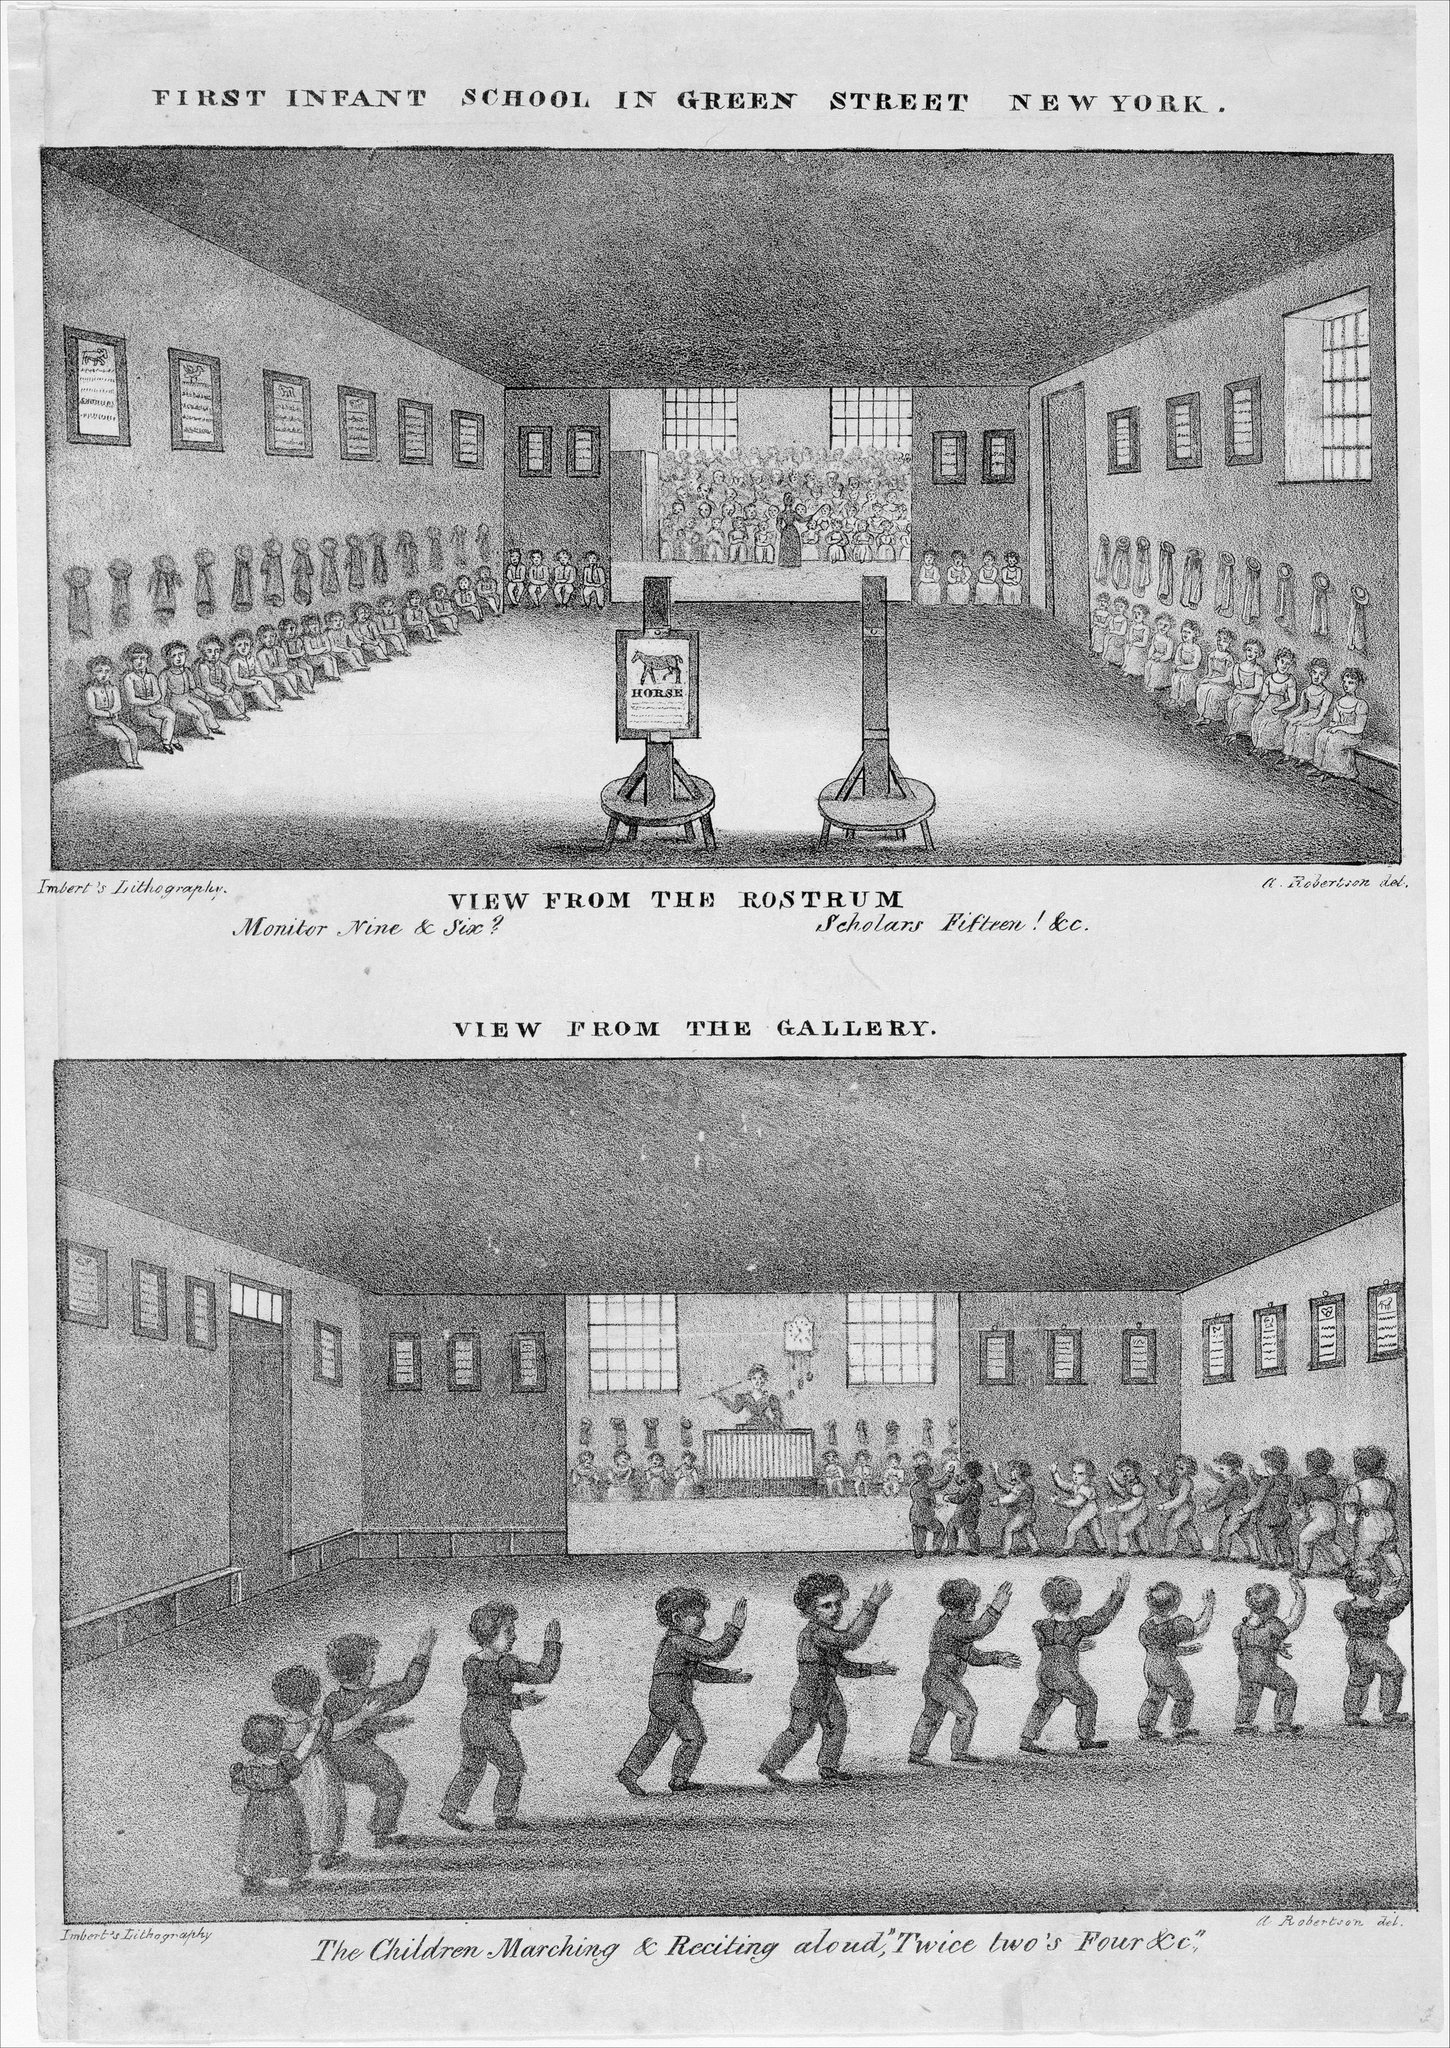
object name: print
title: First Infant School in Green Street, New York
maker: anthony imbert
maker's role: artist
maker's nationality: american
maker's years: 1800-1850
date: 1828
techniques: lithograph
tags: schools,interiors,boys,girls,students,teachers